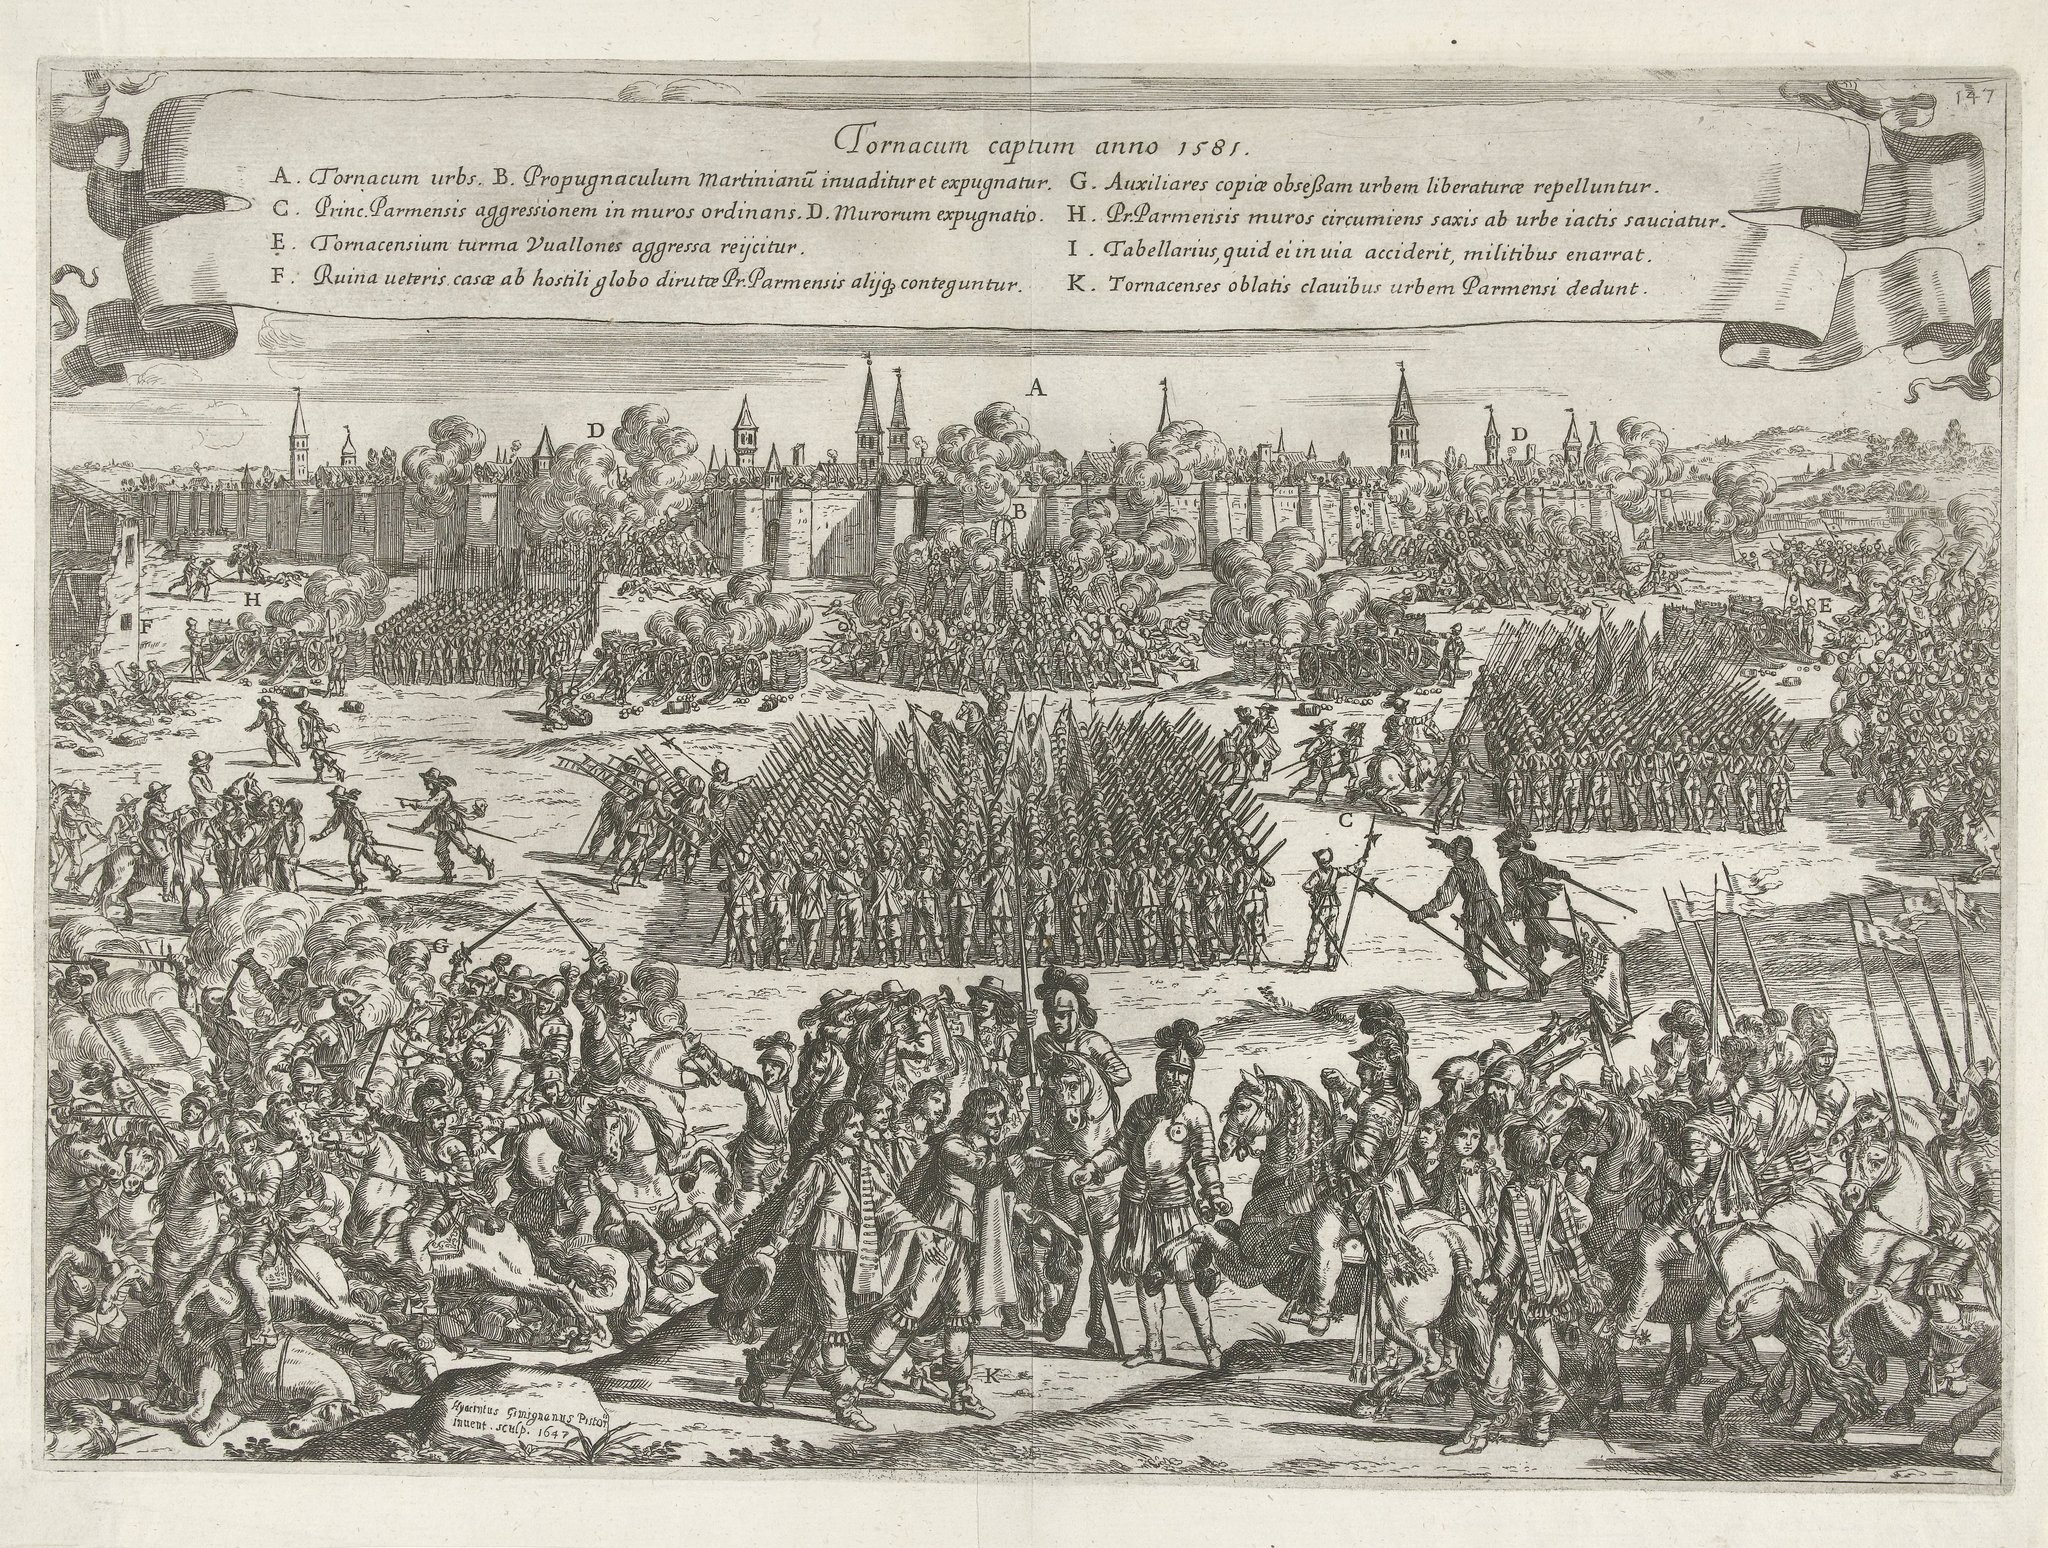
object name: print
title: Inname van Doornik, 1581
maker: giacinto gimignani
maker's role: draughtsman, print maker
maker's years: 1606-1681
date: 1647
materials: paper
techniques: engraving, etching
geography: rome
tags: rome, alessandro farnese (landvoogd van de nederlanden en hertog van parma en piacenza), capture of city (after the siege)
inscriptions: date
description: Verovering van Doornik door de hertog van Parma na een beleg van 1 oktober tot 29 november. Op de voorgrond een ruitergevecht en vertegenwoordigers van de stad die de sleutels van de stad overhandigen aan Parma. Op de achtergrond de belegering van de stad. Bovenaan een banderol met de legenda A-K in het Latijn.